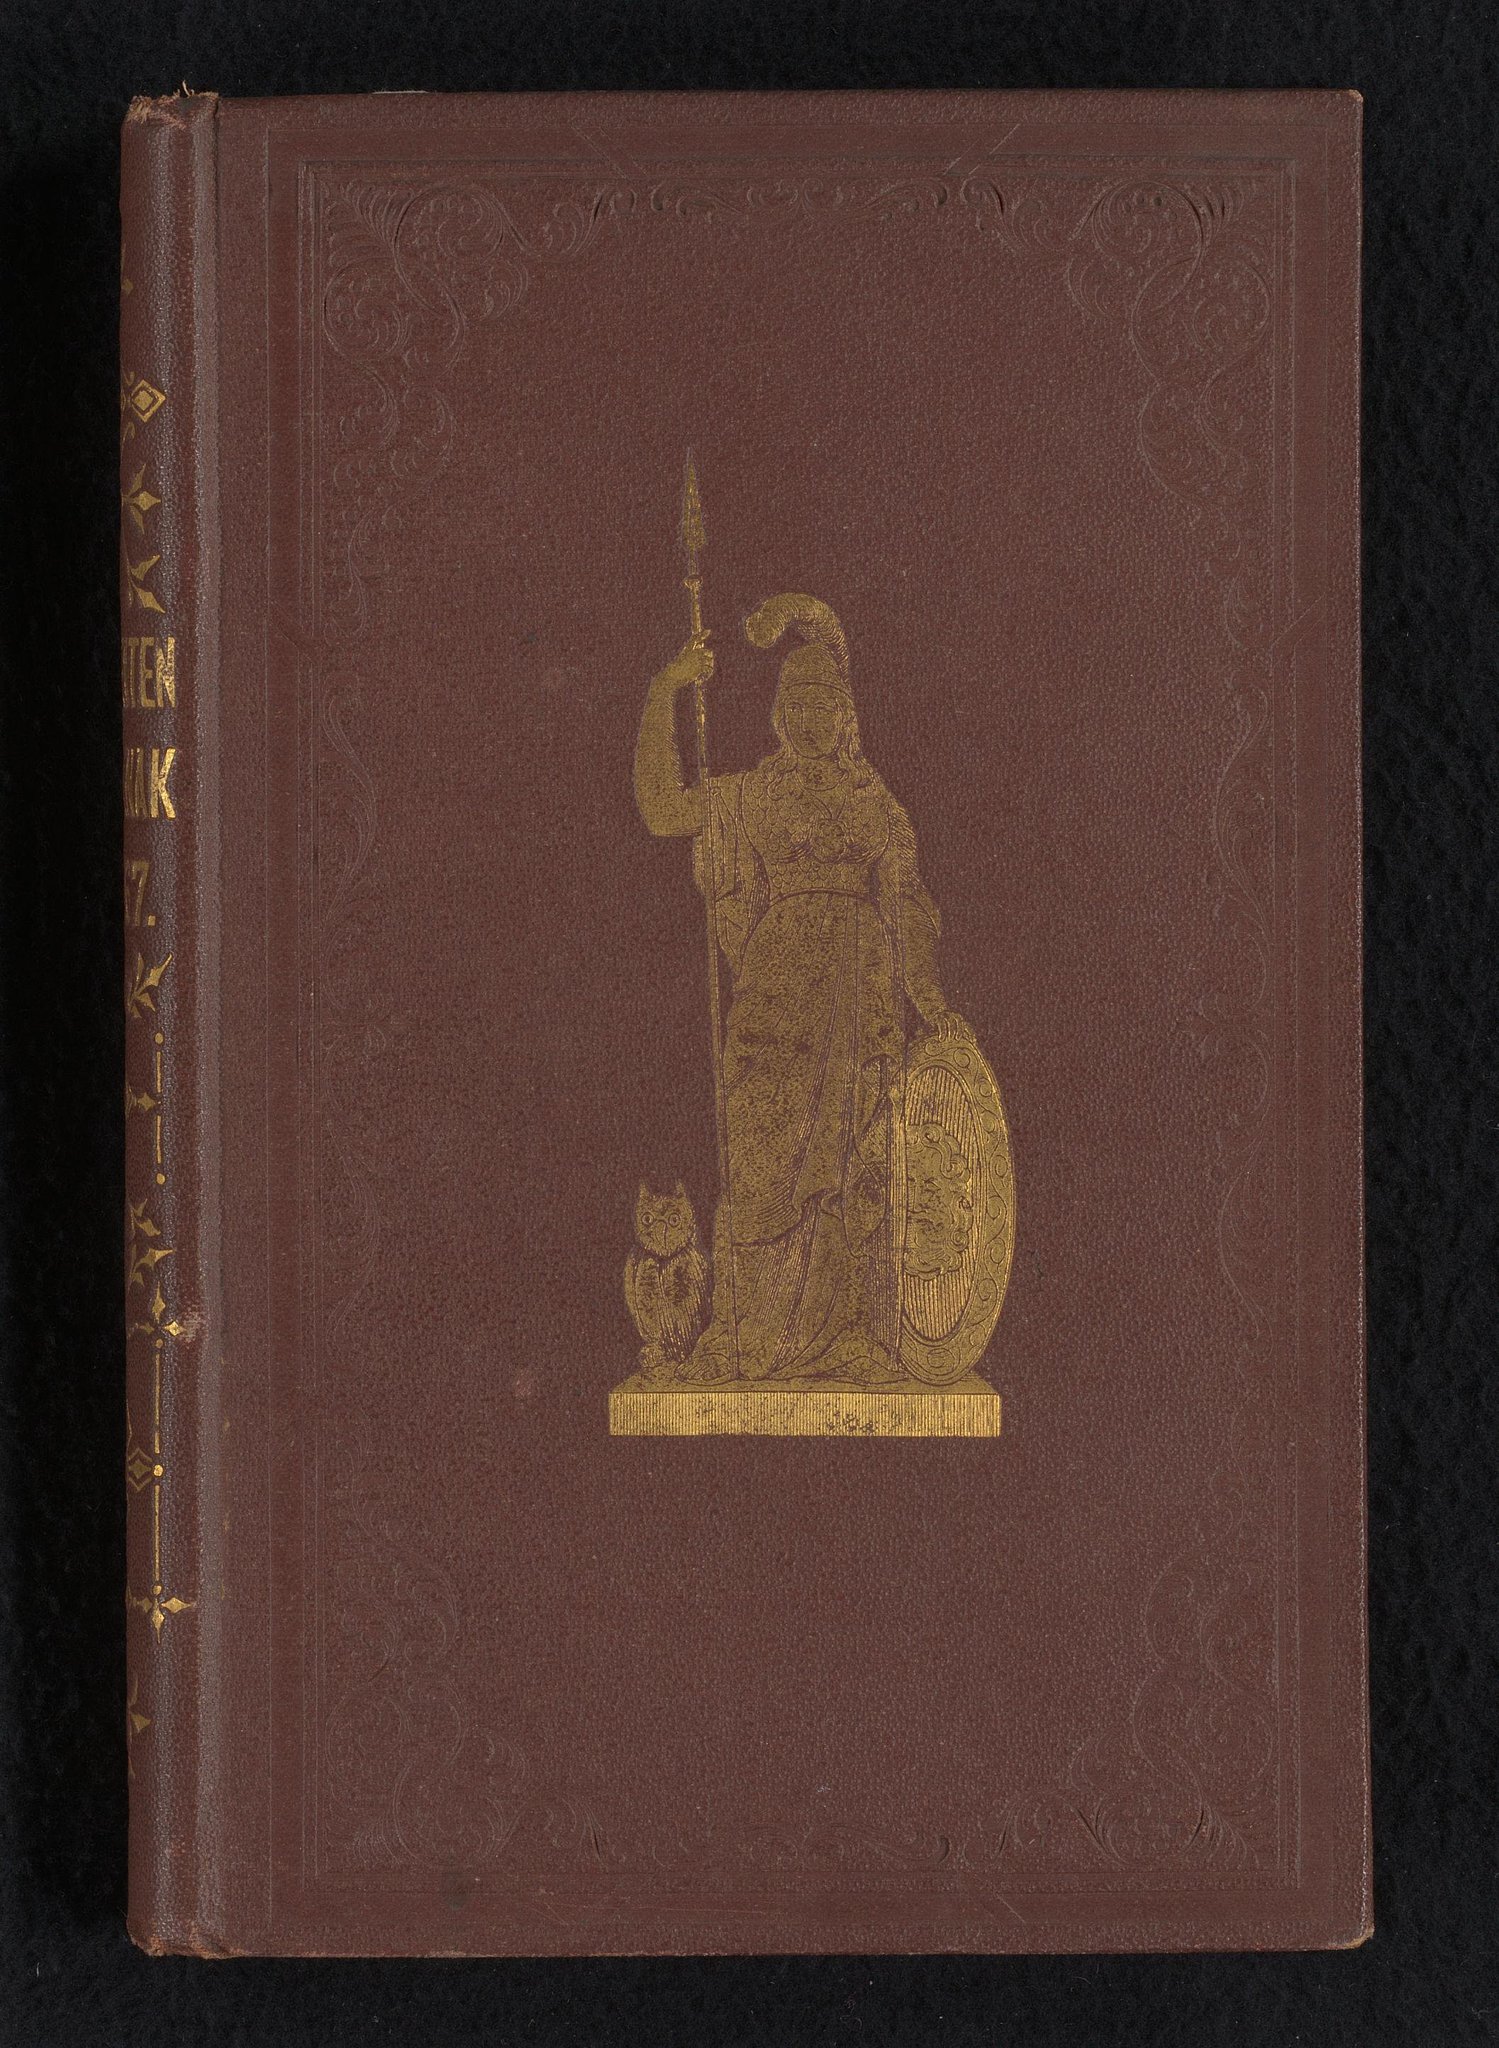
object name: book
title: Utrechtsche studenten-almanak voor hte jaar 1867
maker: pieter wilhelmus van de weijer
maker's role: print maker, printer, publisher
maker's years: 1816-1880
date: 1866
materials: paper, cardboard, leather, linen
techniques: albumen print, letterpress printing, lithograph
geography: utrecht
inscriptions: number: ‘48316’, inscription: ‘gekocht dec. 1964 f2,50/ bij Kok Amsterdam/ 2 foto's naast pag 128’